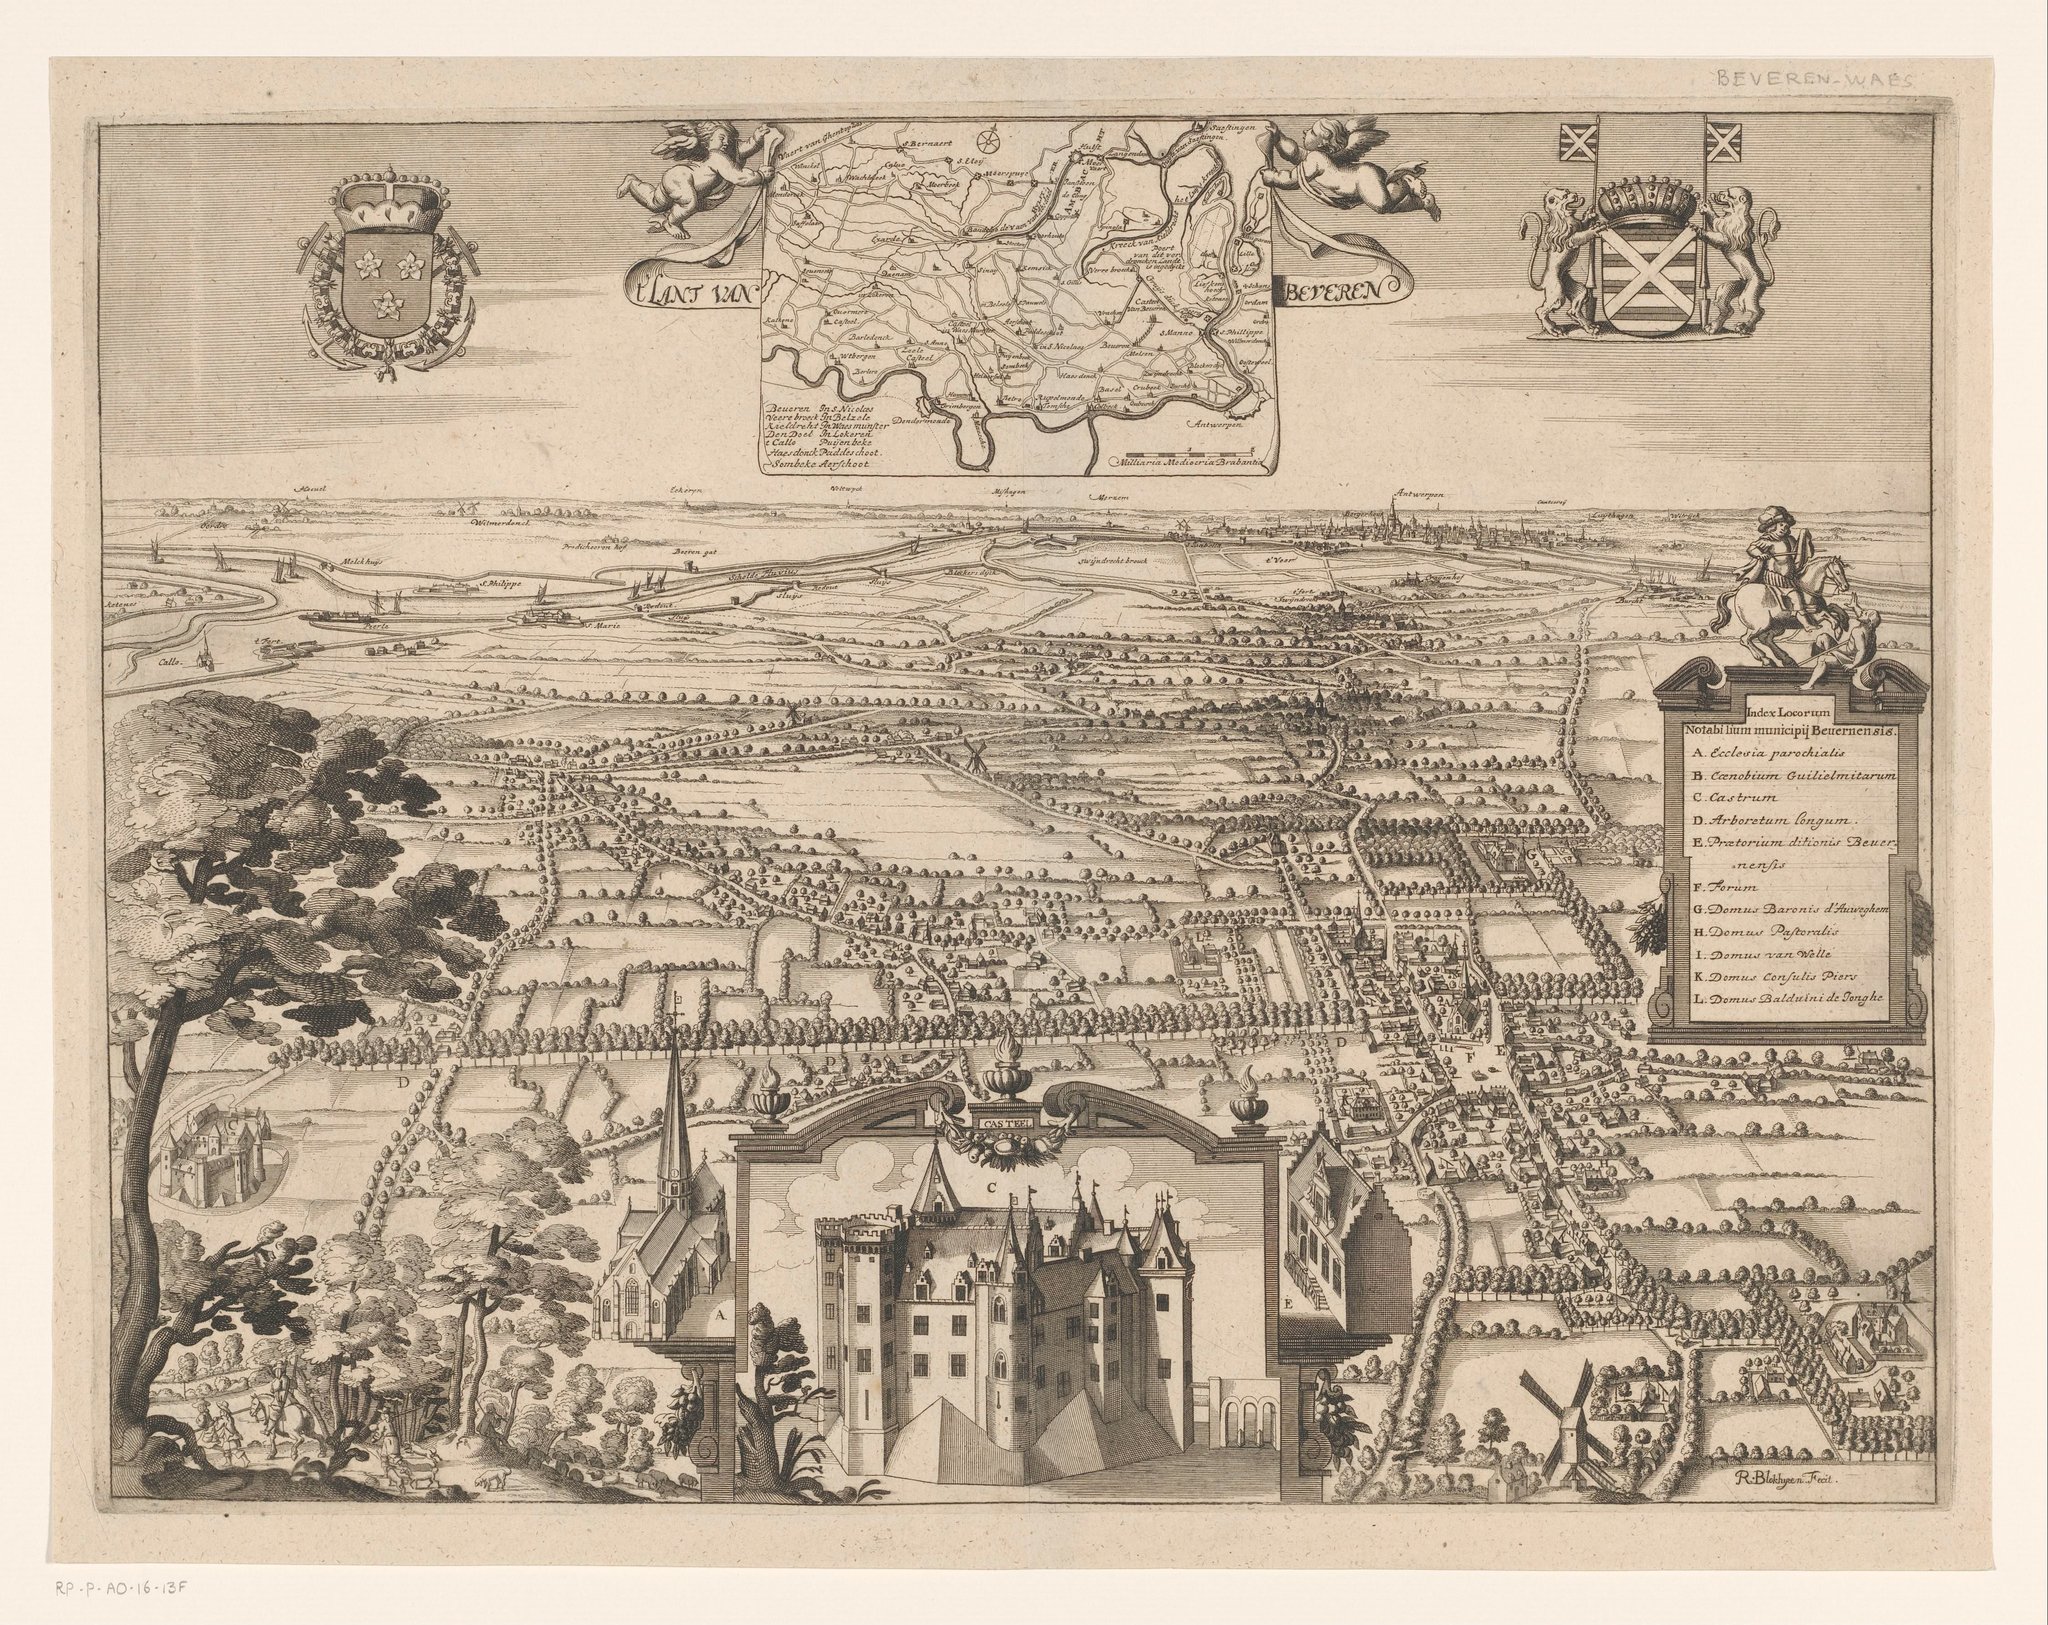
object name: print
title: t' Lant van Beveren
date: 1735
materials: paper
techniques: engraving, etching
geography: leiden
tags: prospect of village, silhouette of village, coat of arms (as symbol of the state, etc.) (+ city; municipal), maps of separate countries or regions, castle, church (exterior), armorial bearing, heraldry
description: Gezicht in vogelvluchtperspectief op het Land van Beveren. Onder een inzet met een gezicht op het kasteel, de kerk en het stadhuis van het dorp Beveren. Boven een inzet met een kaart van de omgeving van Beveren met schaalstok: 2 Milliaria Mediocria Brabantia. Aan weerszijden van de kaart een putto, die samen een banderol met titel vasthouden. Linksboven het wapen van de hertogen van Arenberg. Rechtsboven het wapen van Beveren. Rechts een legenda A-L.